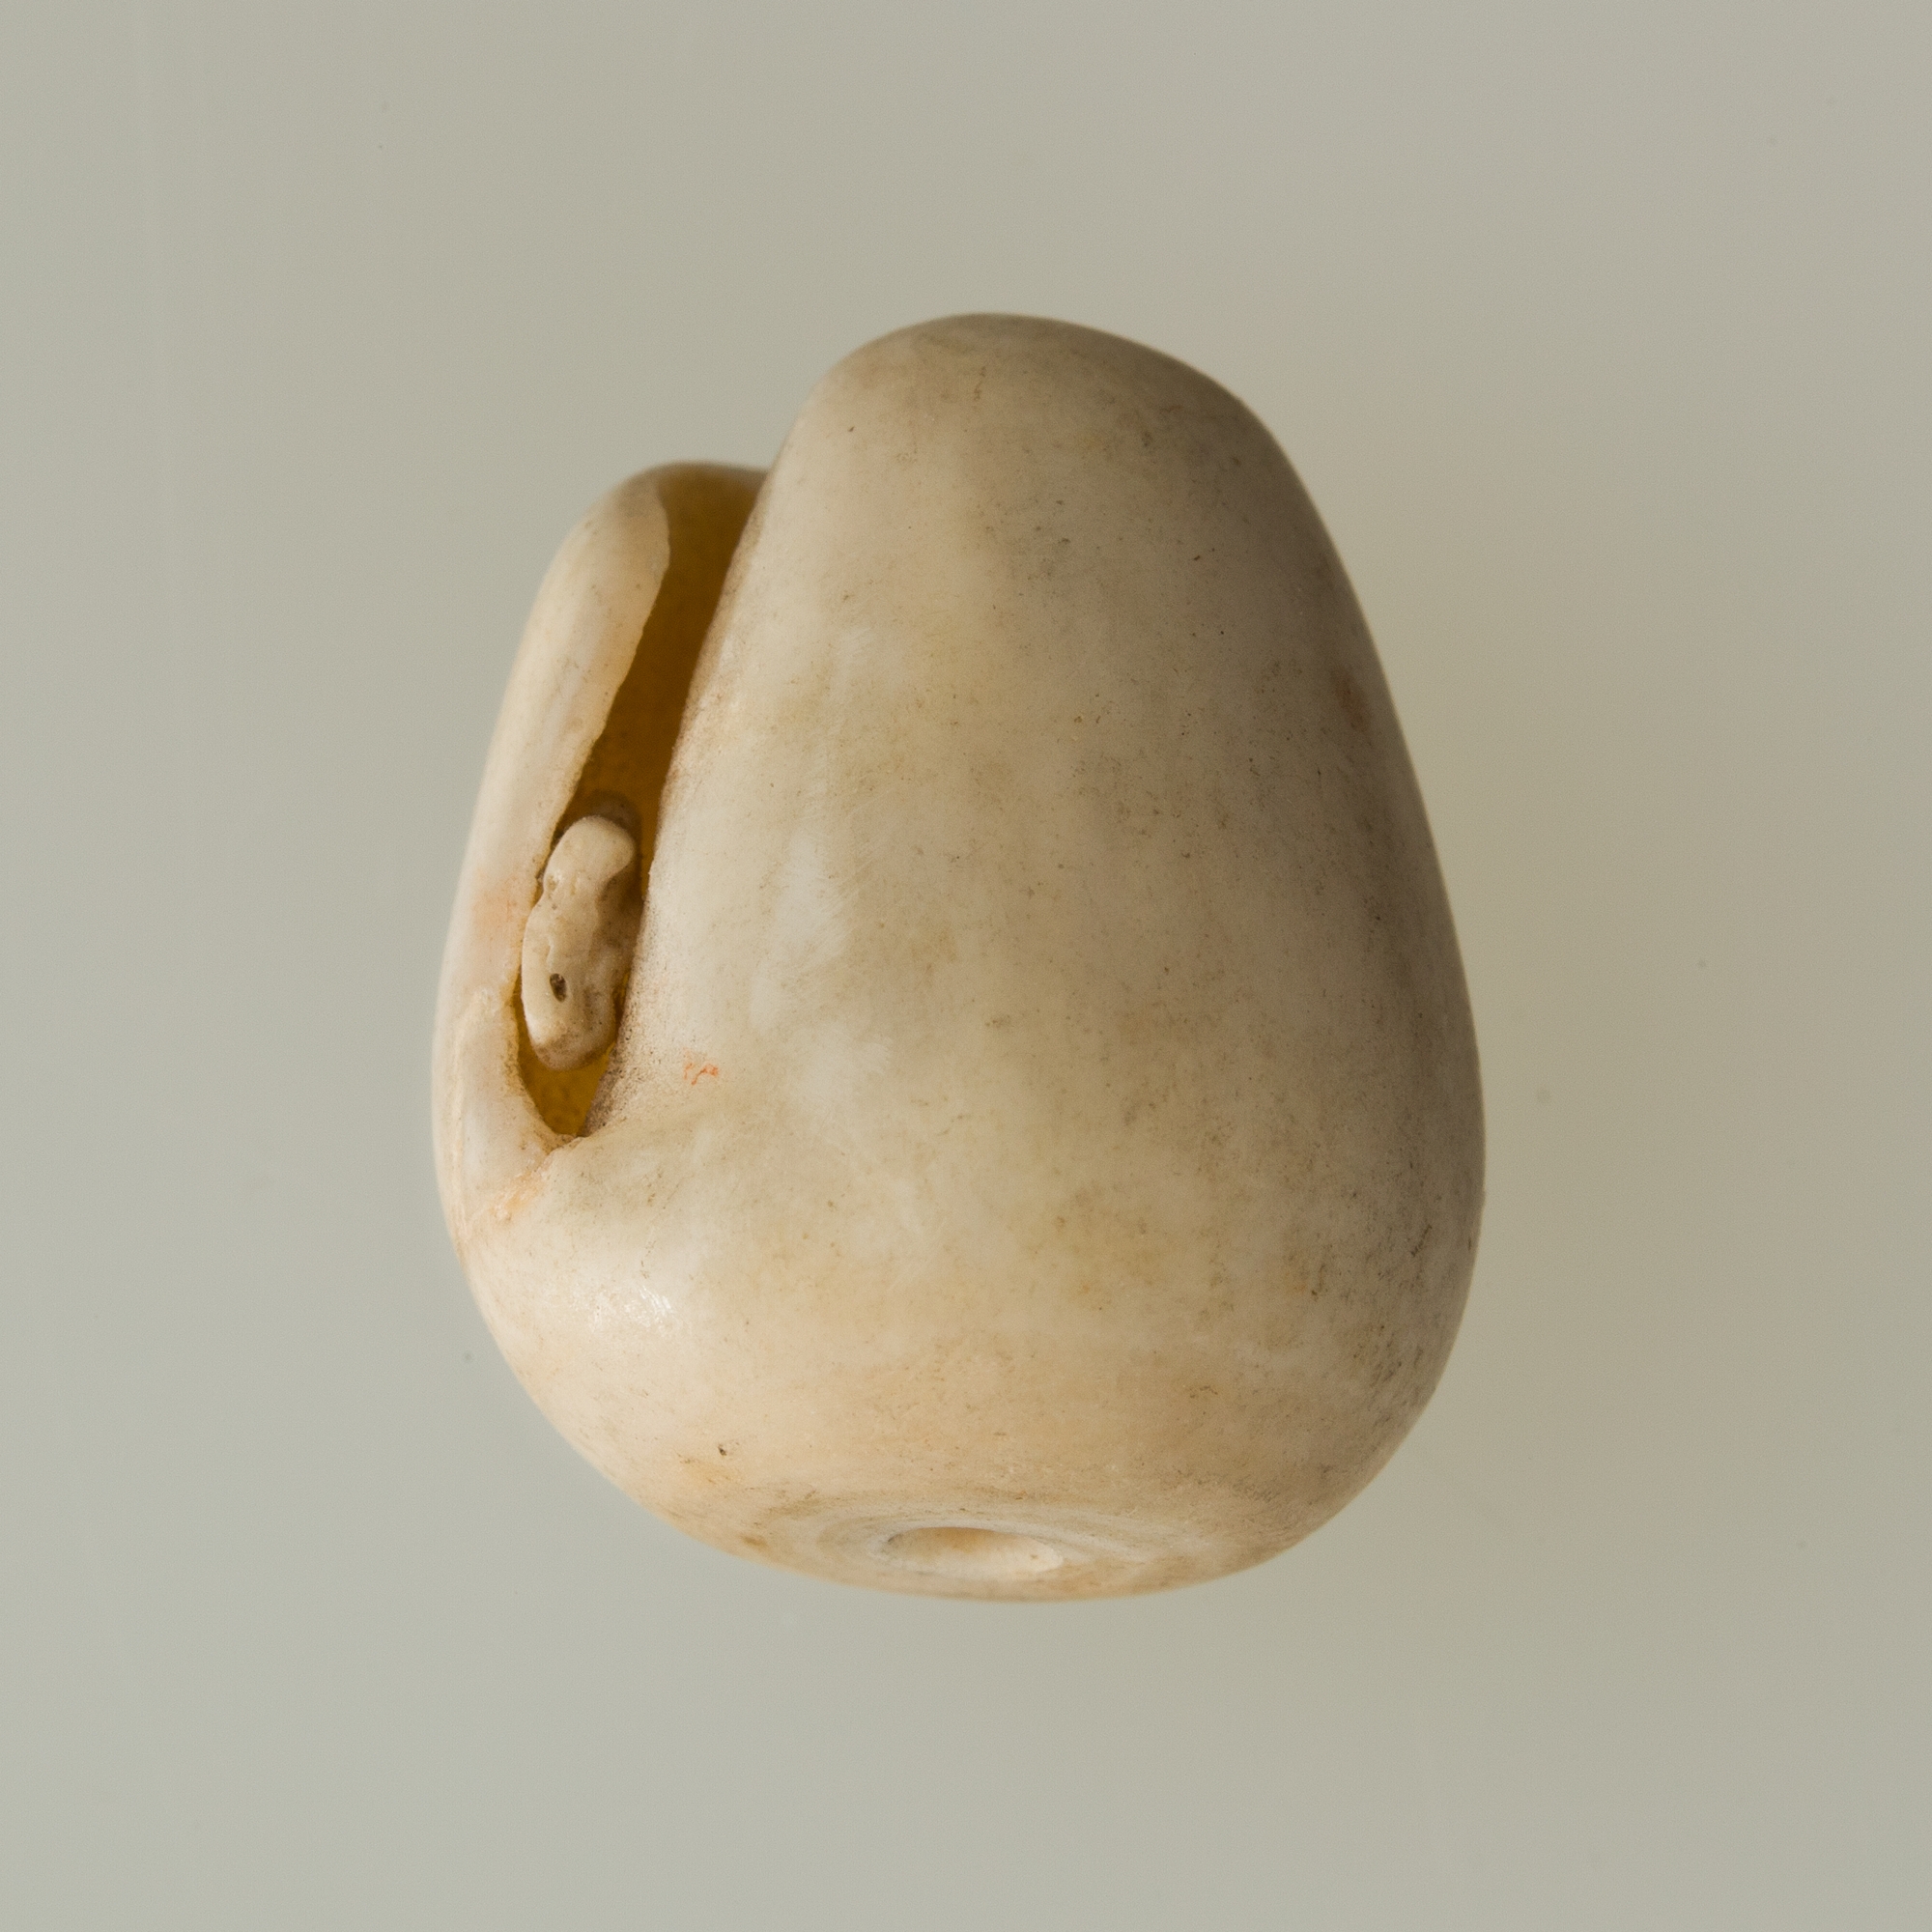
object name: pendant, shell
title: Shell pendant or bead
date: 3850-2960 BCE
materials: shell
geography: egypt